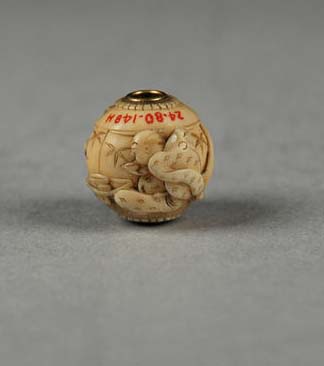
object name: bead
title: Carved Bead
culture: japanese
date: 1801-1900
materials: ivory